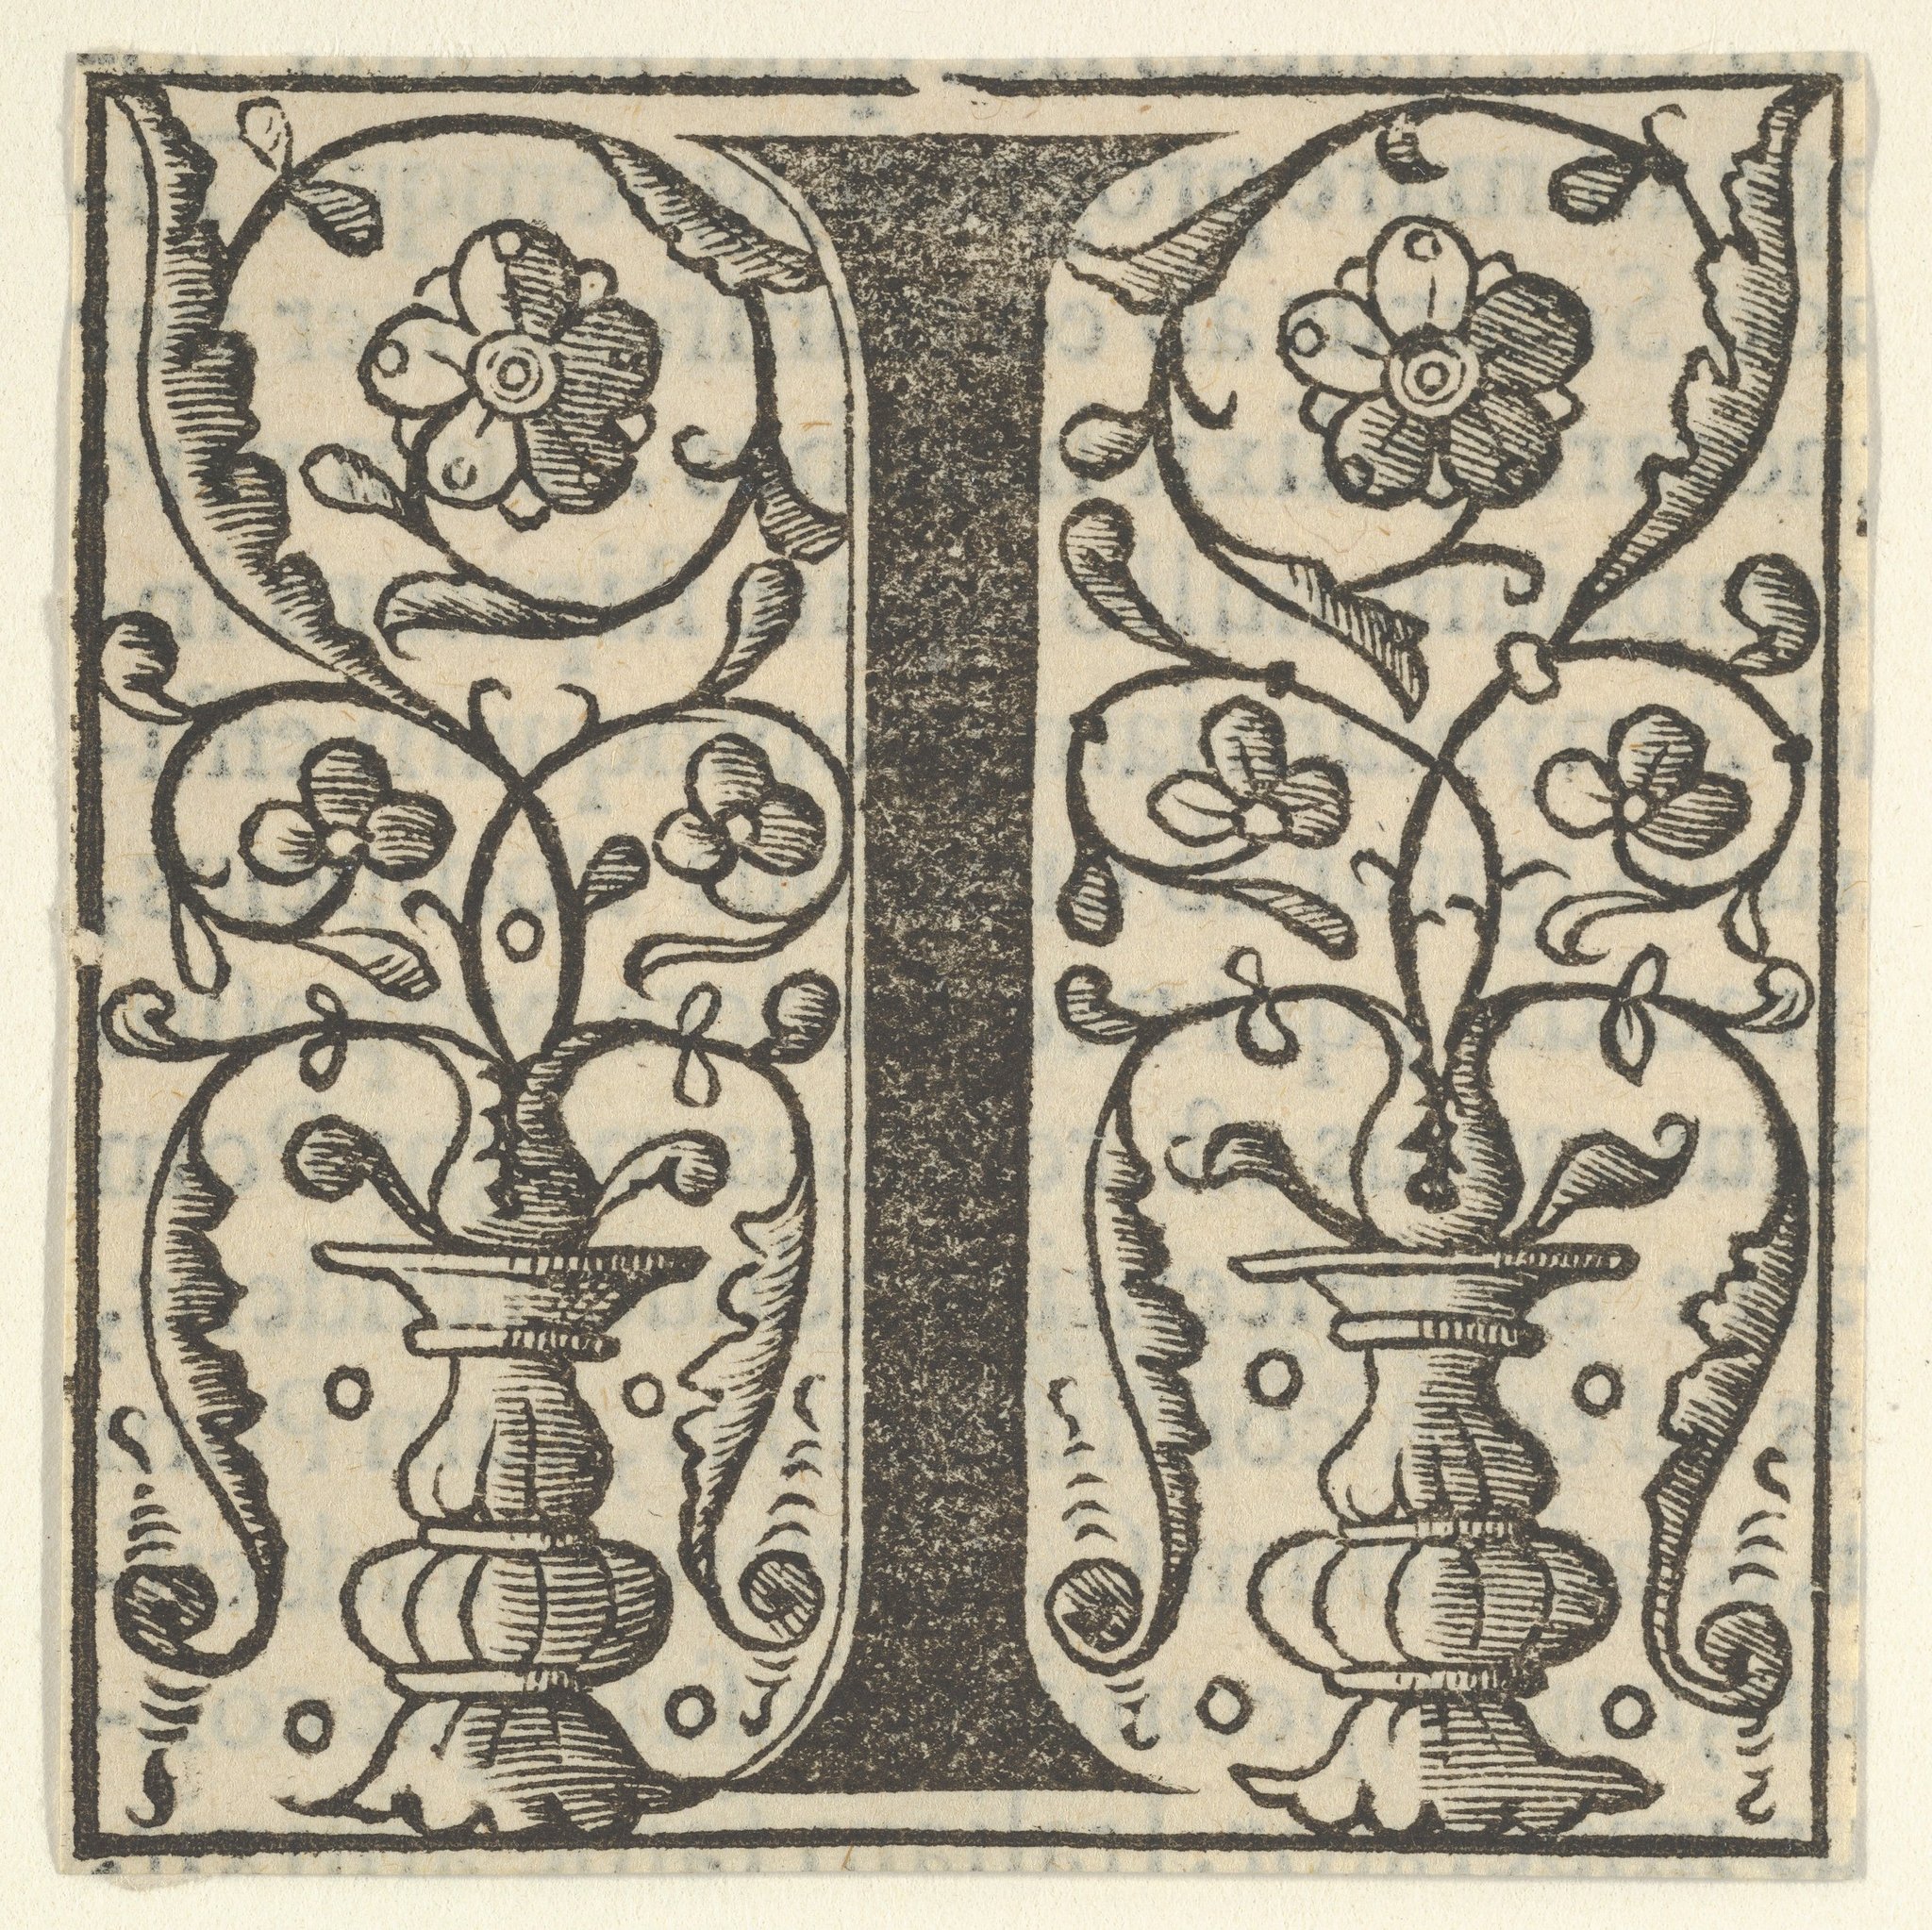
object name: print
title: Initial letter I with garlands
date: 1534-1566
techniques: woodcut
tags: flowers,leaves,vases